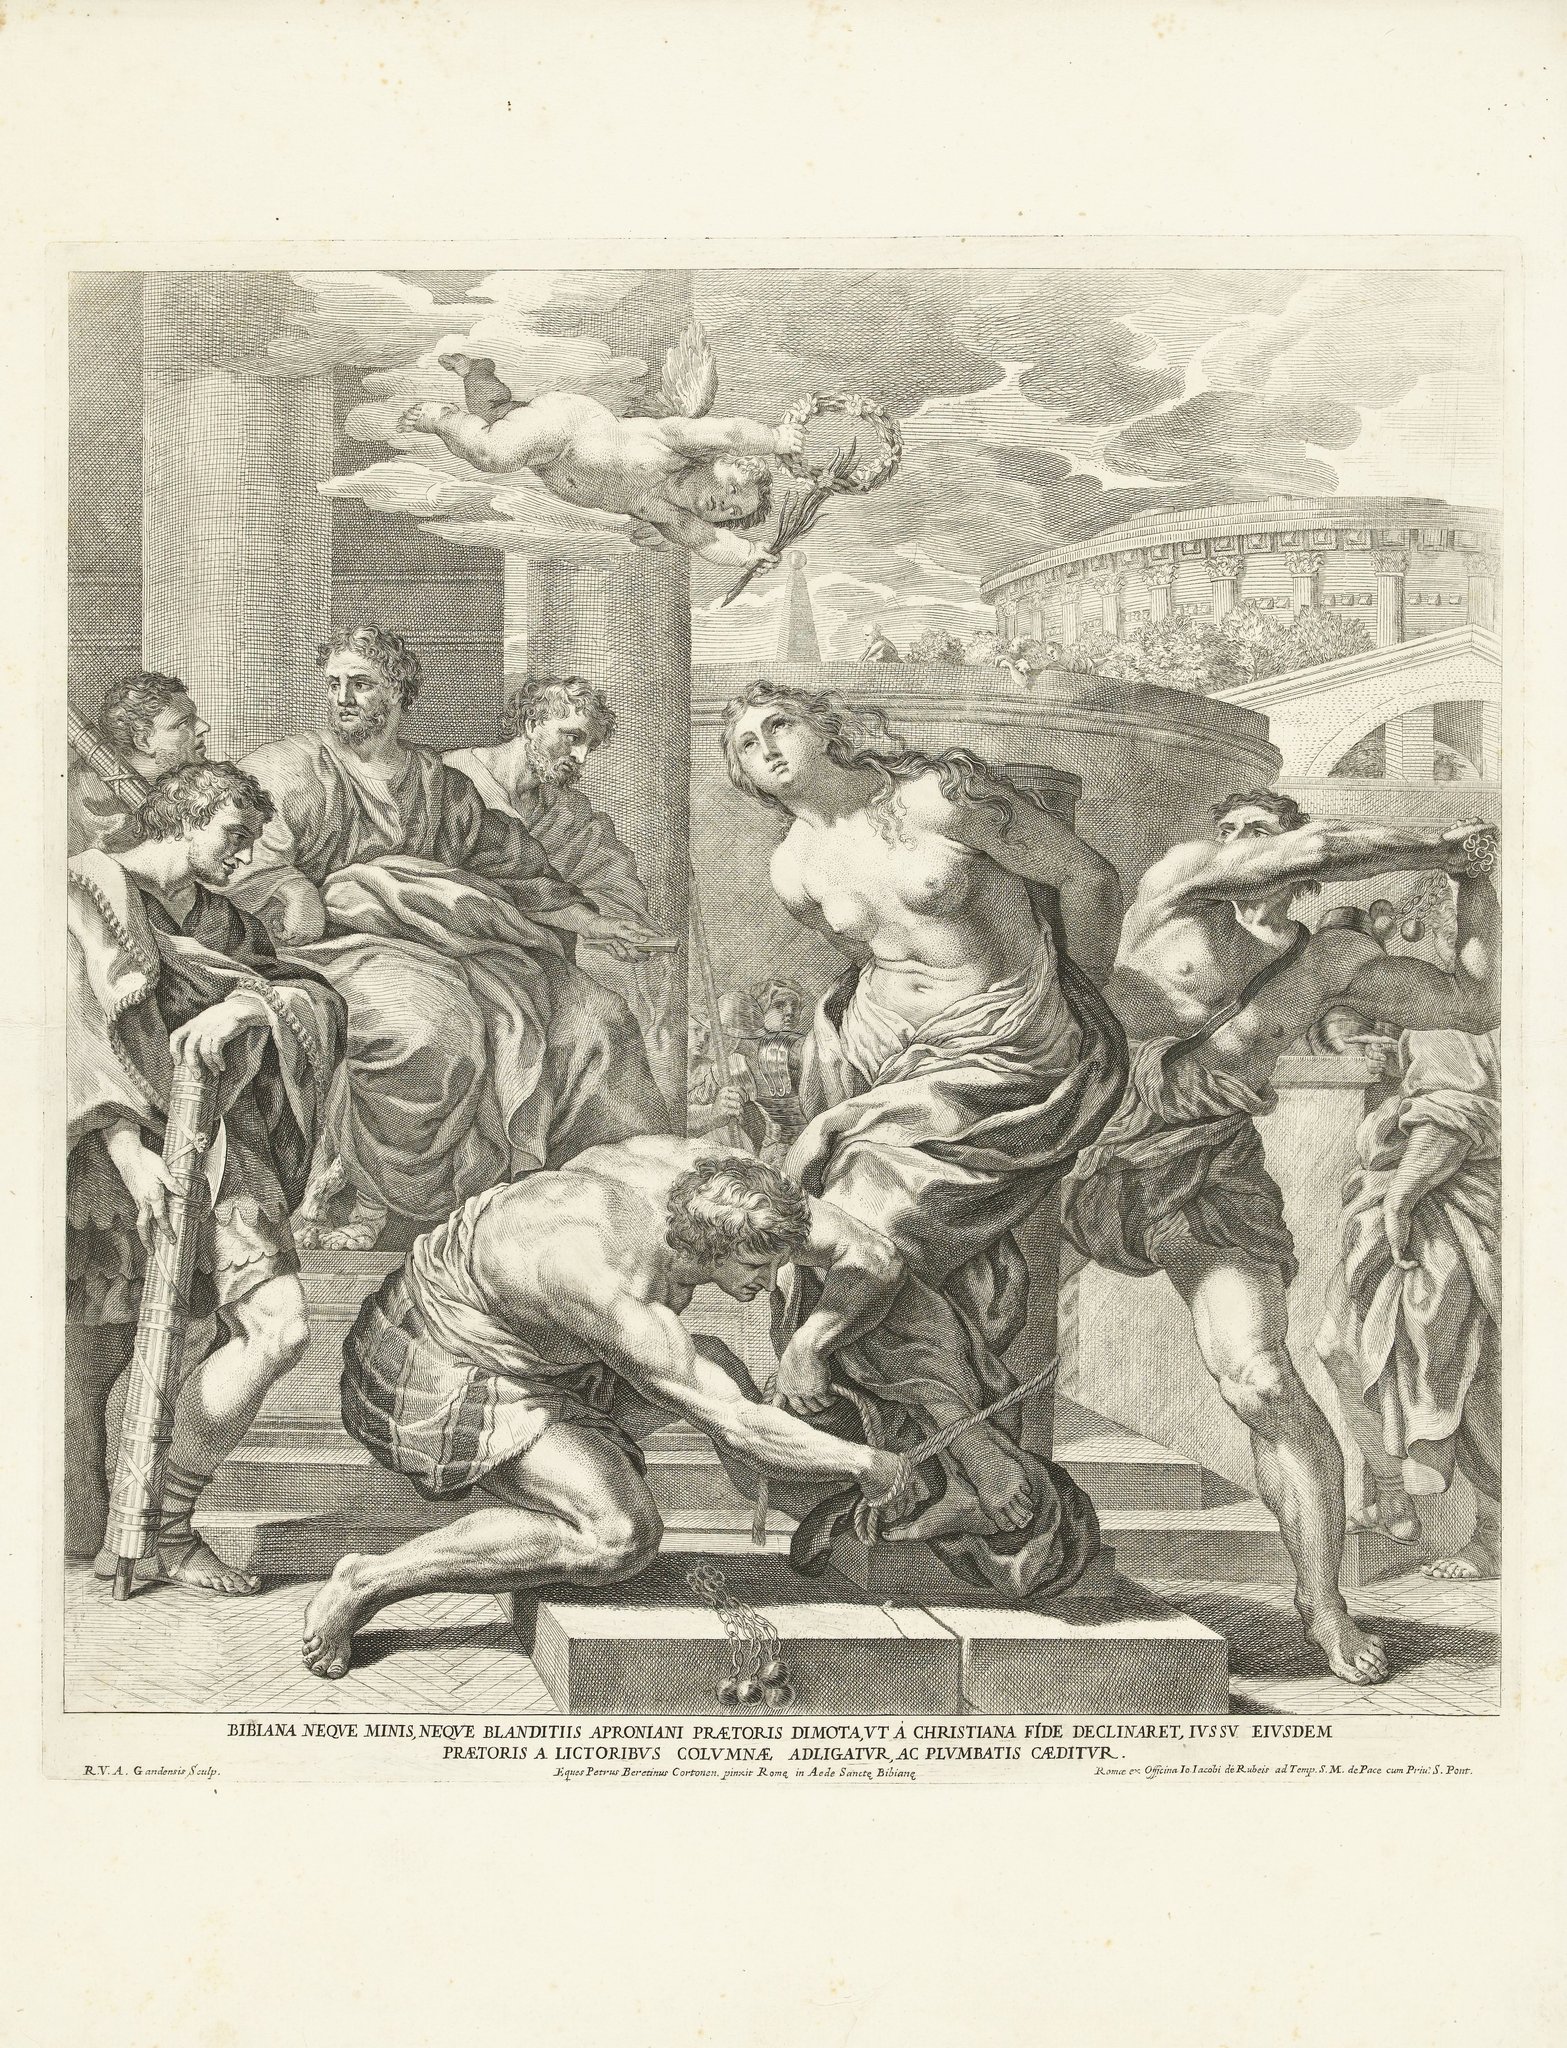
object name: print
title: Bibiana aan een zuil gebonden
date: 1685-1691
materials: paper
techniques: engraving, etching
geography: rome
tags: female saints (with name), female saints (with name) - martyrdom, suffering, misfortune, death of female saint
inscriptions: collector's mark: Lugt 240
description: Bibiana die zich blijft verzeten tegen de Romeinse gouverneur Apronianus wordt aan een zuil vastgebonden en gemarteld.